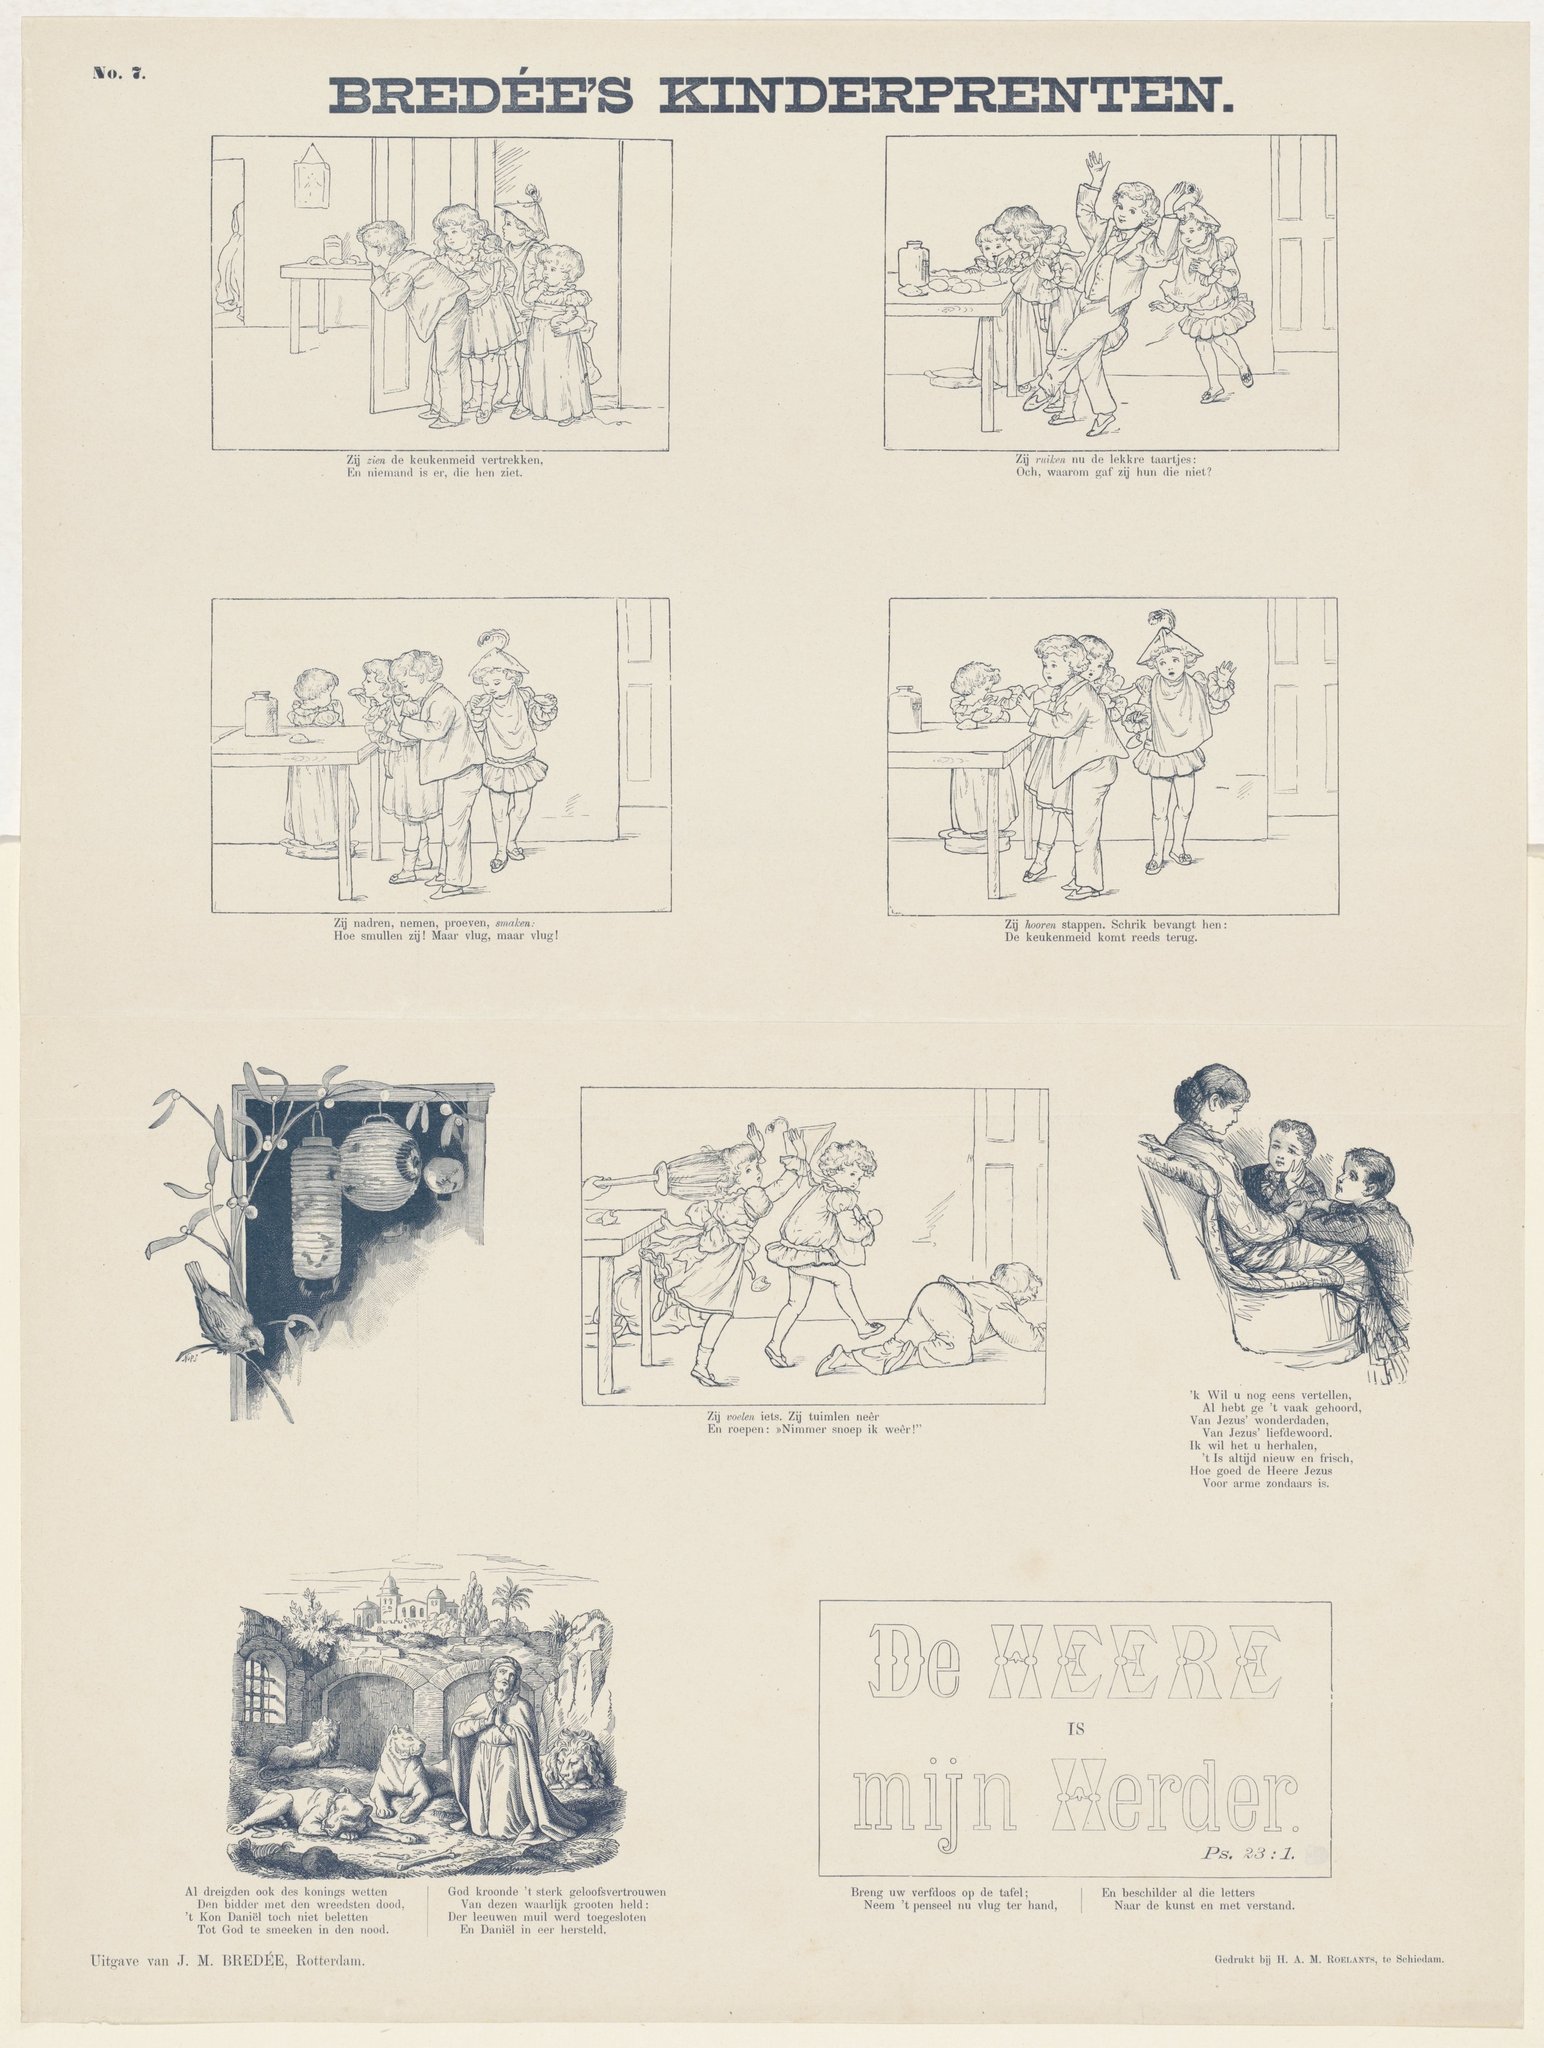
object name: print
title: Verschillende voorstellingen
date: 1894-1918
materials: paper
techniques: letterpress printing, line block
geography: schiedam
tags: correction of naughty children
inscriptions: collector's mark: Lugt 2760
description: Blad met 9 voorstellingen van verschillende aard, waaronder vijf scènes met ondeugende kinderen die stiekem taart eten als de keukenmeid even weg gaat, en vervolgens worden gestraft. Onder elke afbeelding twee tot acht regels vers. Genummerd linksboven: No. 7.